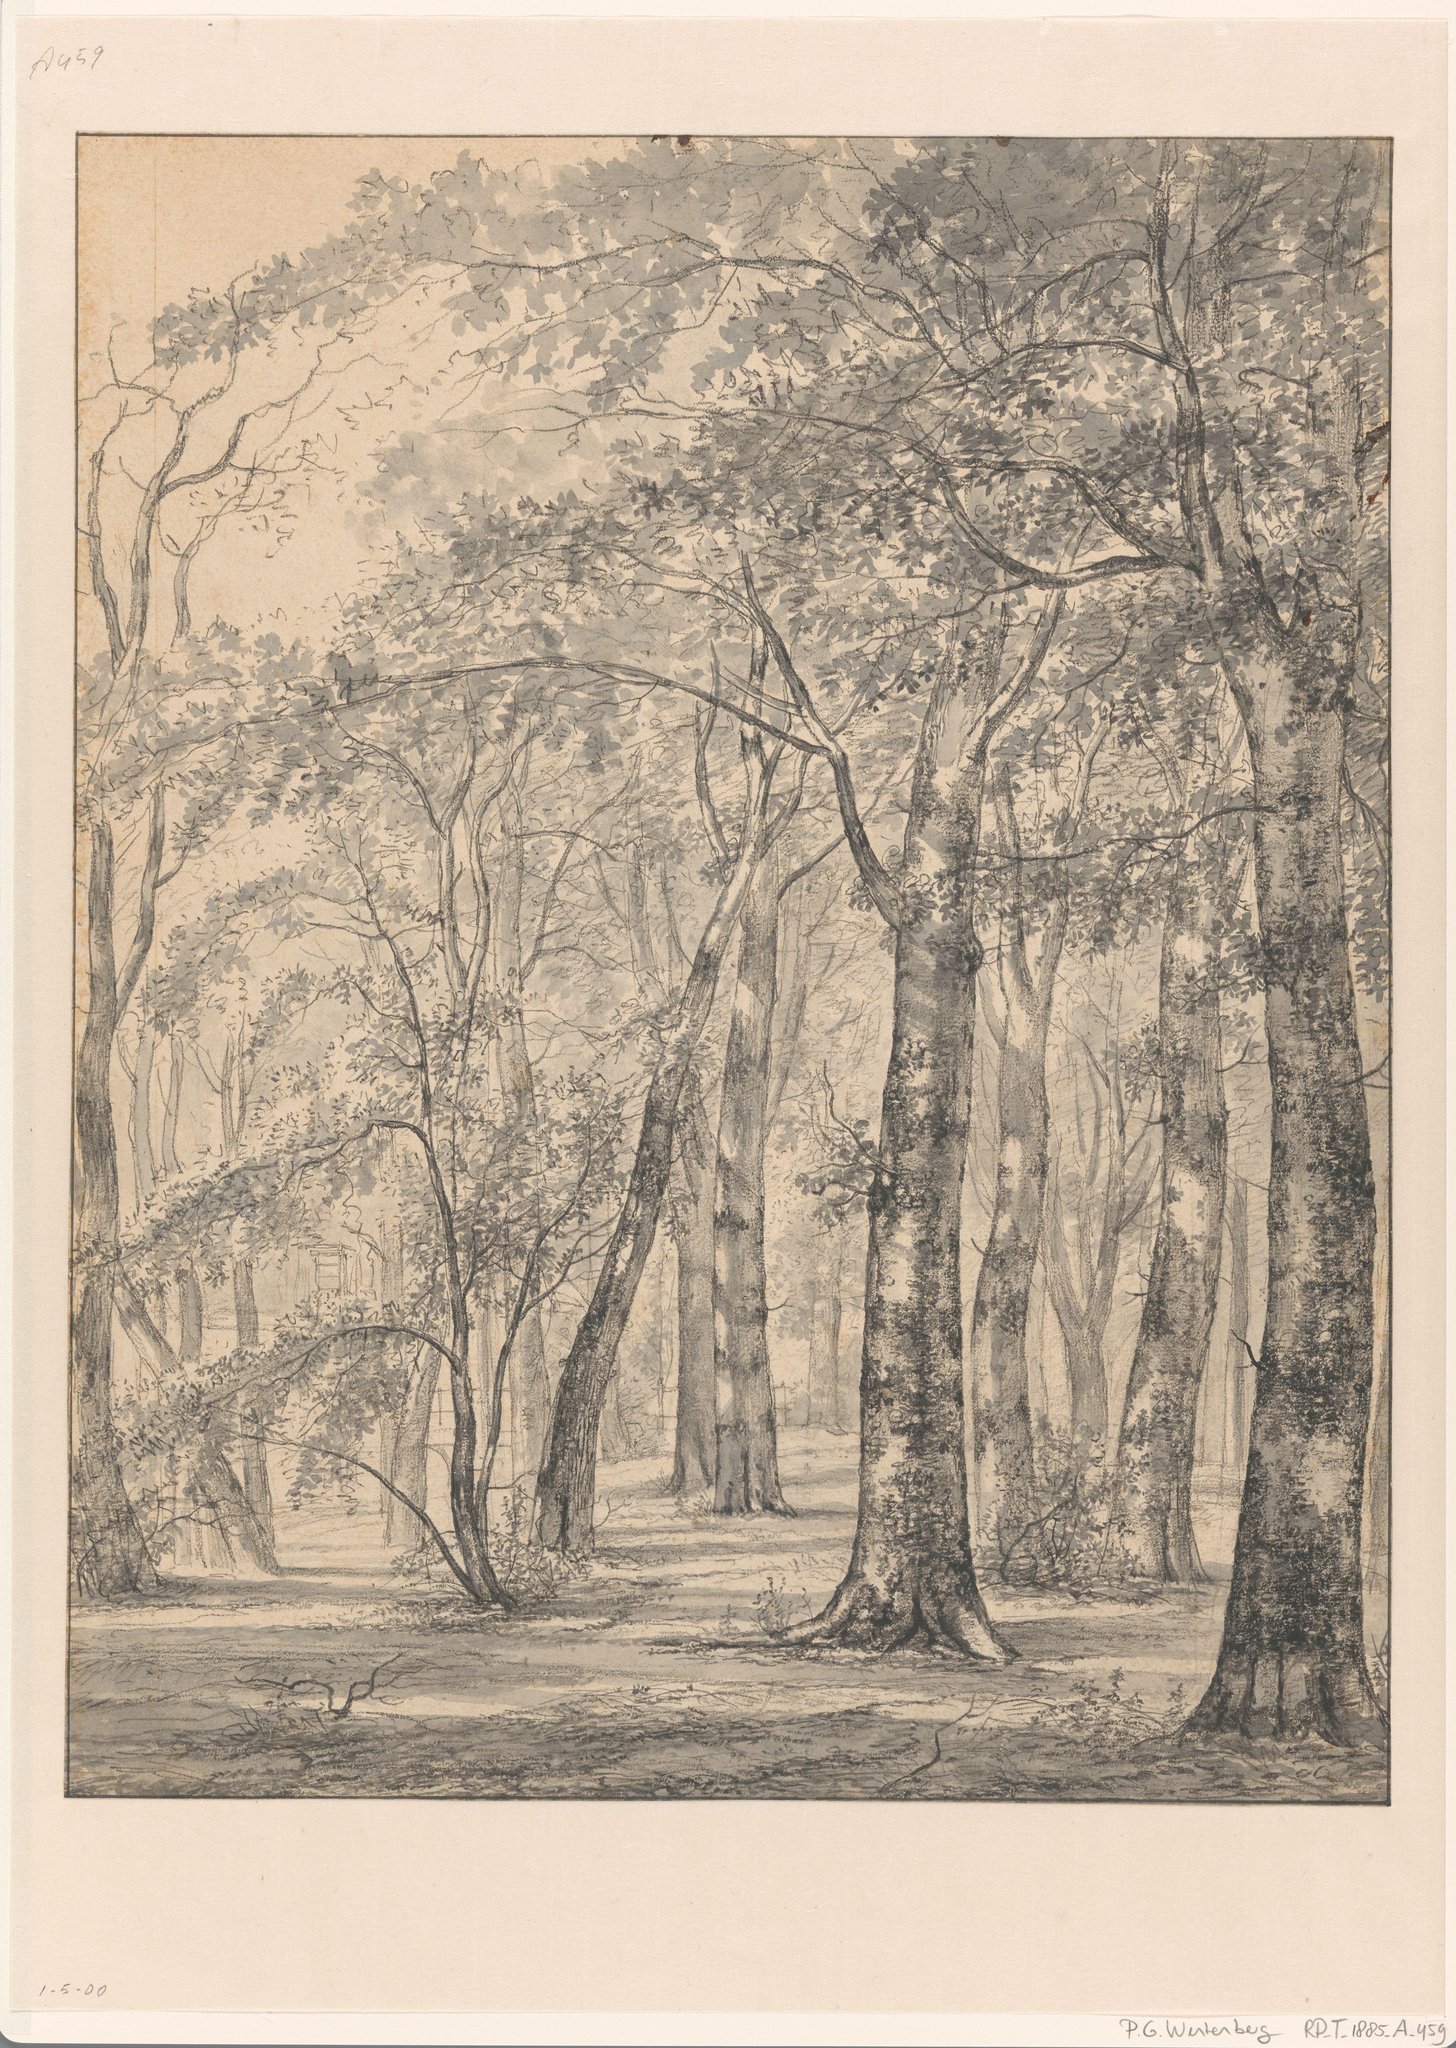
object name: drawing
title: Bosgezicht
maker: george pieter westenberg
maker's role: draughtsman, painter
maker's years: 1791-1873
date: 1801-1873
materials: chalk, ink, paper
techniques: brush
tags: trees: birch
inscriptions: collector's mark: Lugt 2228